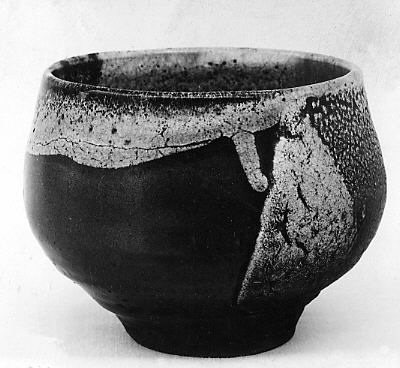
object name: teabowl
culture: japanese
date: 1701-1800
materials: clay, glaze